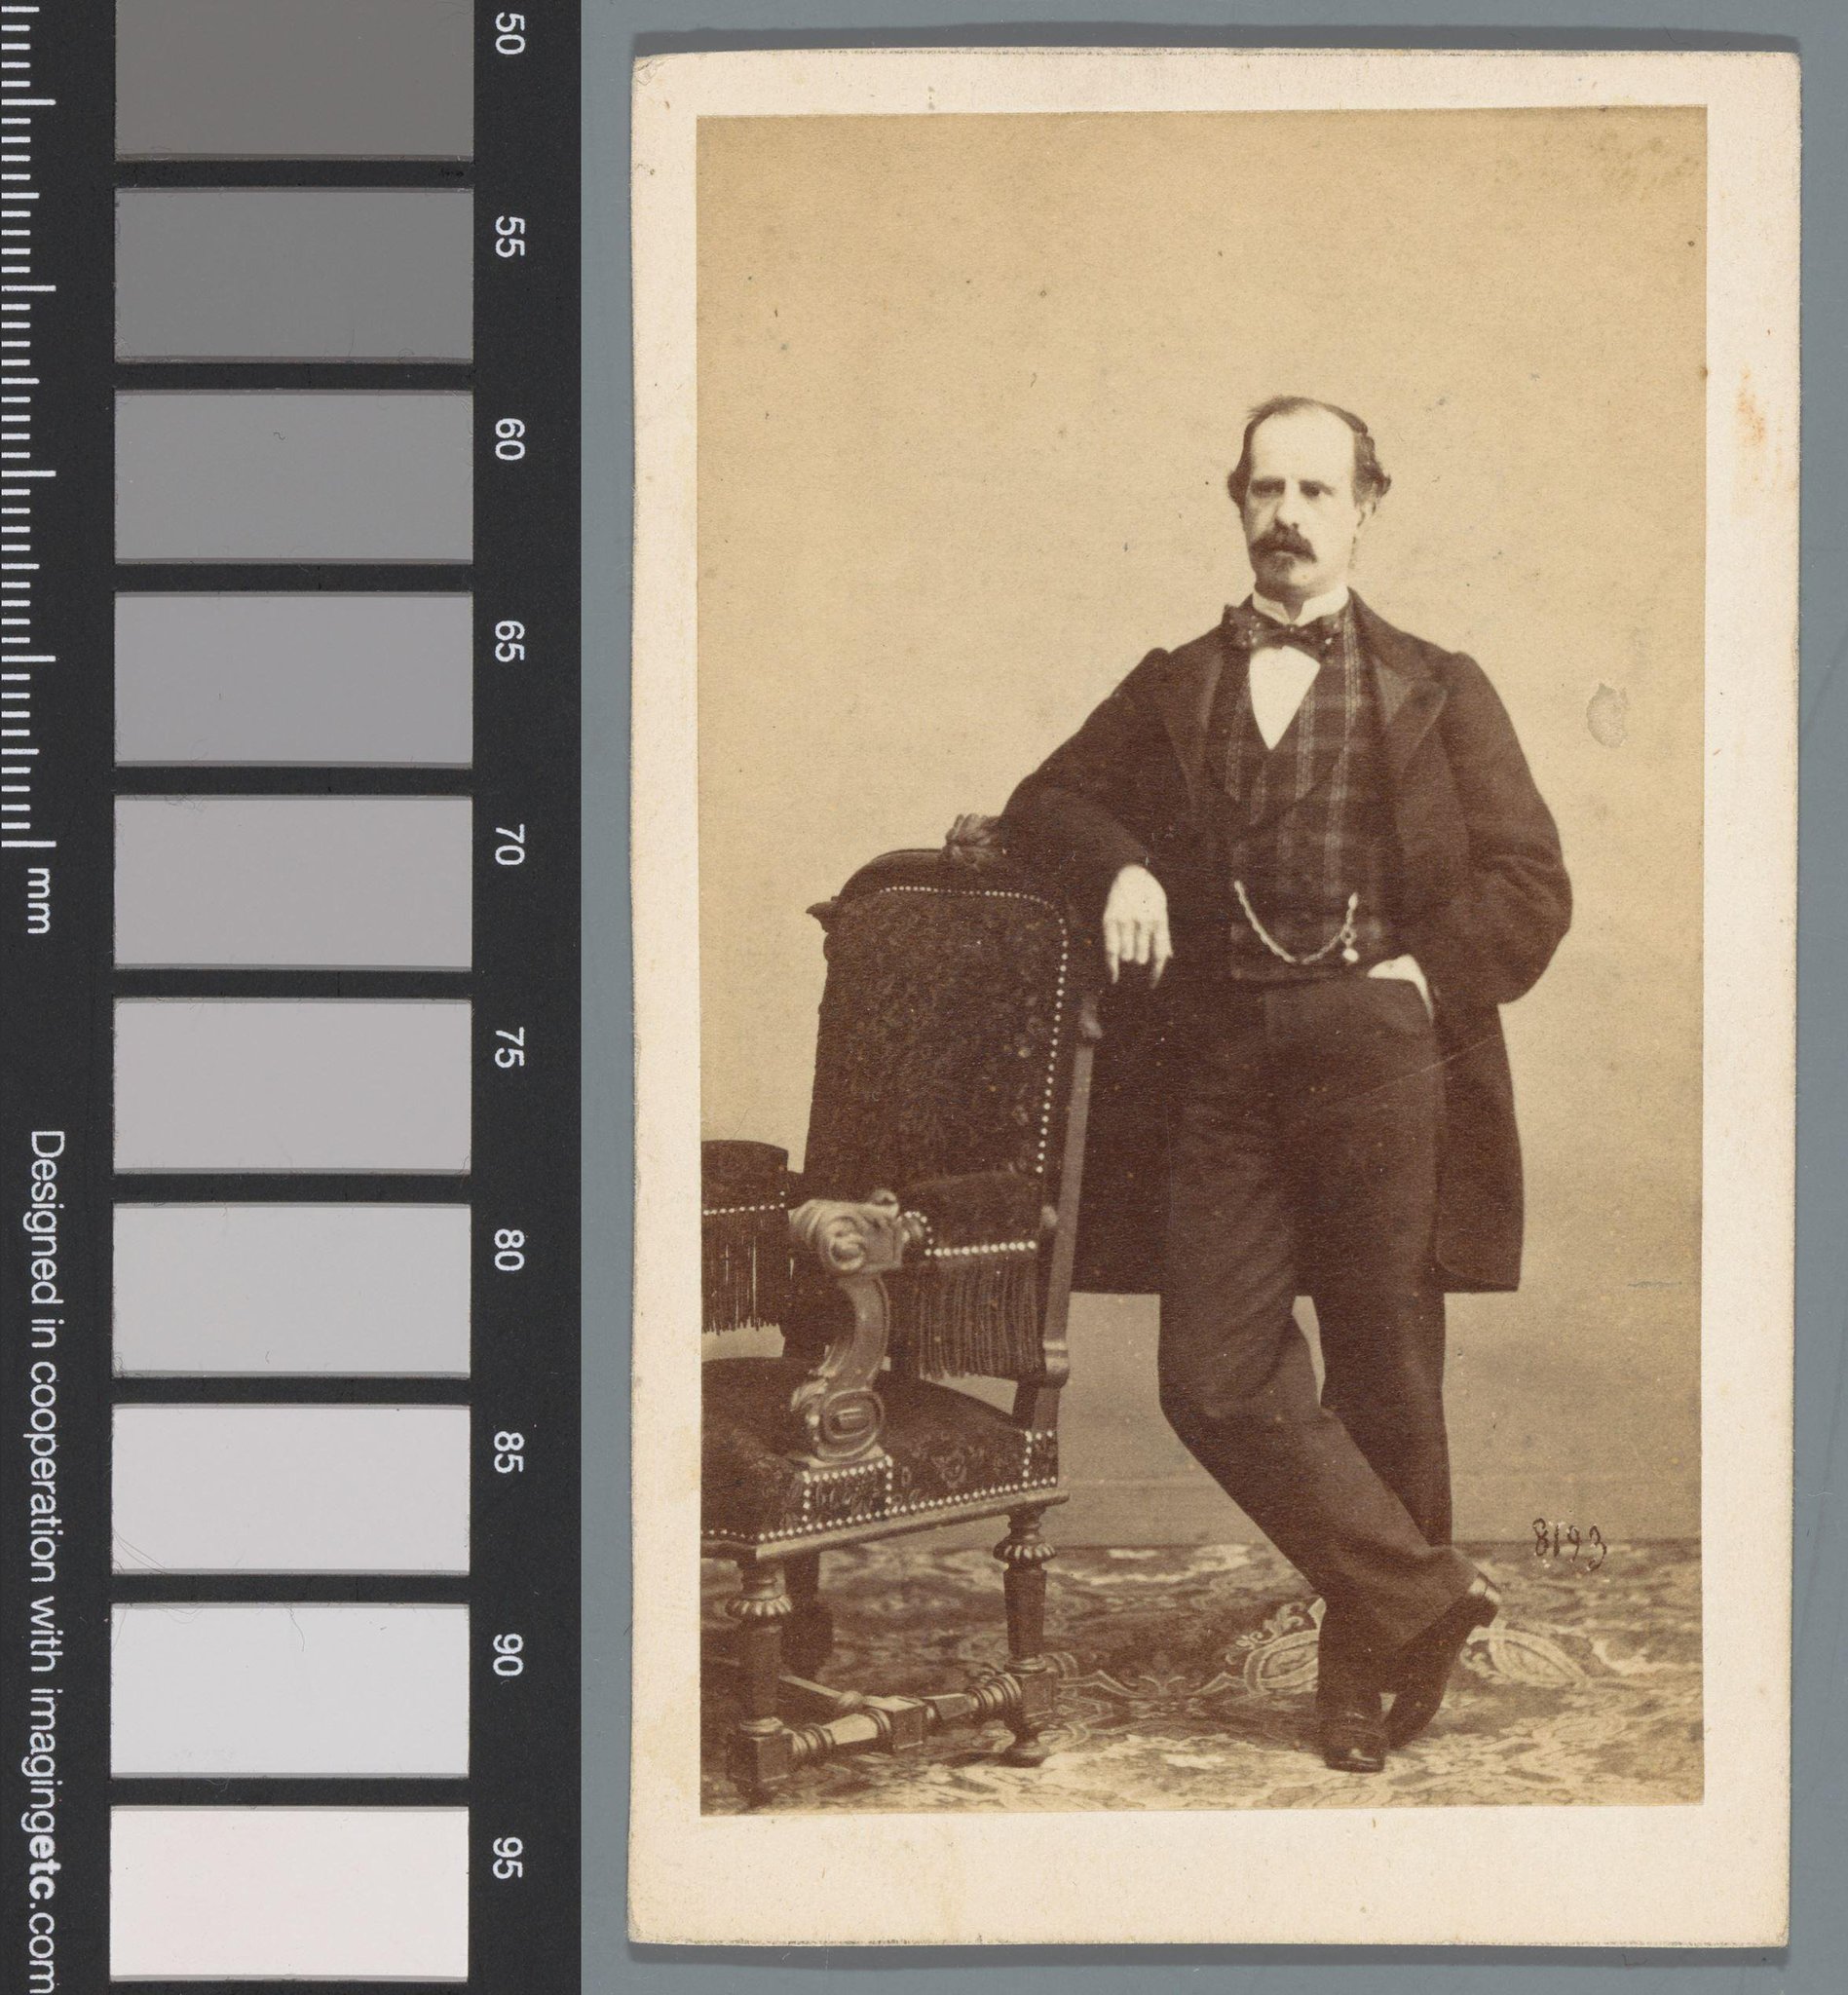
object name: carte de visite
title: Portret van een onbekende man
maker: juan laurent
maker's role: publisher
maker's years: 1816-1896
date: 1855-1885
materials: cardboard, paper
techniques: albumen print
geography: madrid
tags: adult man, anonymous historical person portrayed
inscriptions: number: ‘8193’, inscription: ‘J. Laurent/ Fotografo de S.M. la Reina/ 39, Carrera S. Geronimo/ Madrid’